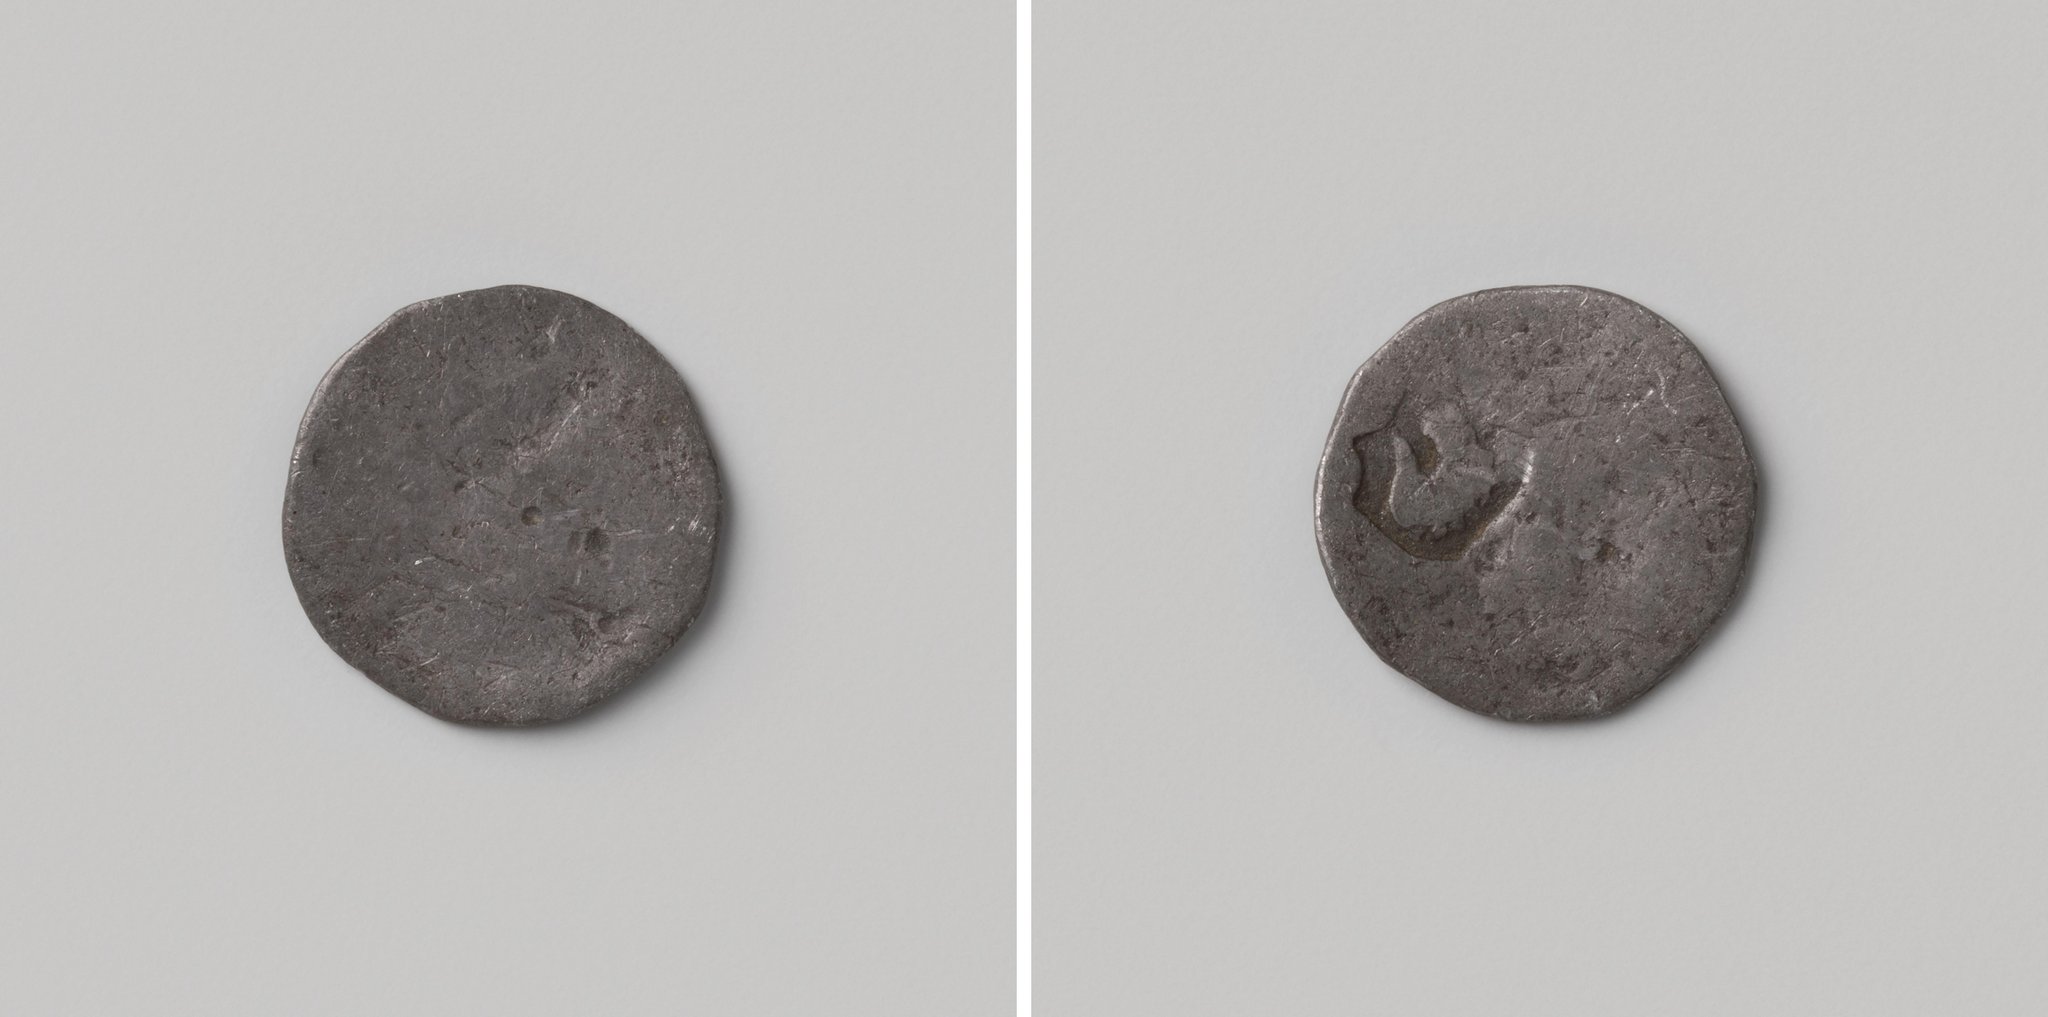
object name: monetary token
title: Correctiehuis Sint Bernhard te Hemiksem, huismunt ter waarde van een halve cent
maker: joseph pierre braemt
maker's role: print maker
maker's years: 1796-1864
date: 1826-1833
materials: zinc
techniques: striking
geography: brussels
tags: ghent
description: Zinken betaalpenning. Voorzijde: opschrift binnen omschrift. Keerzijde: waardeaanduiding; links klop: paardekop